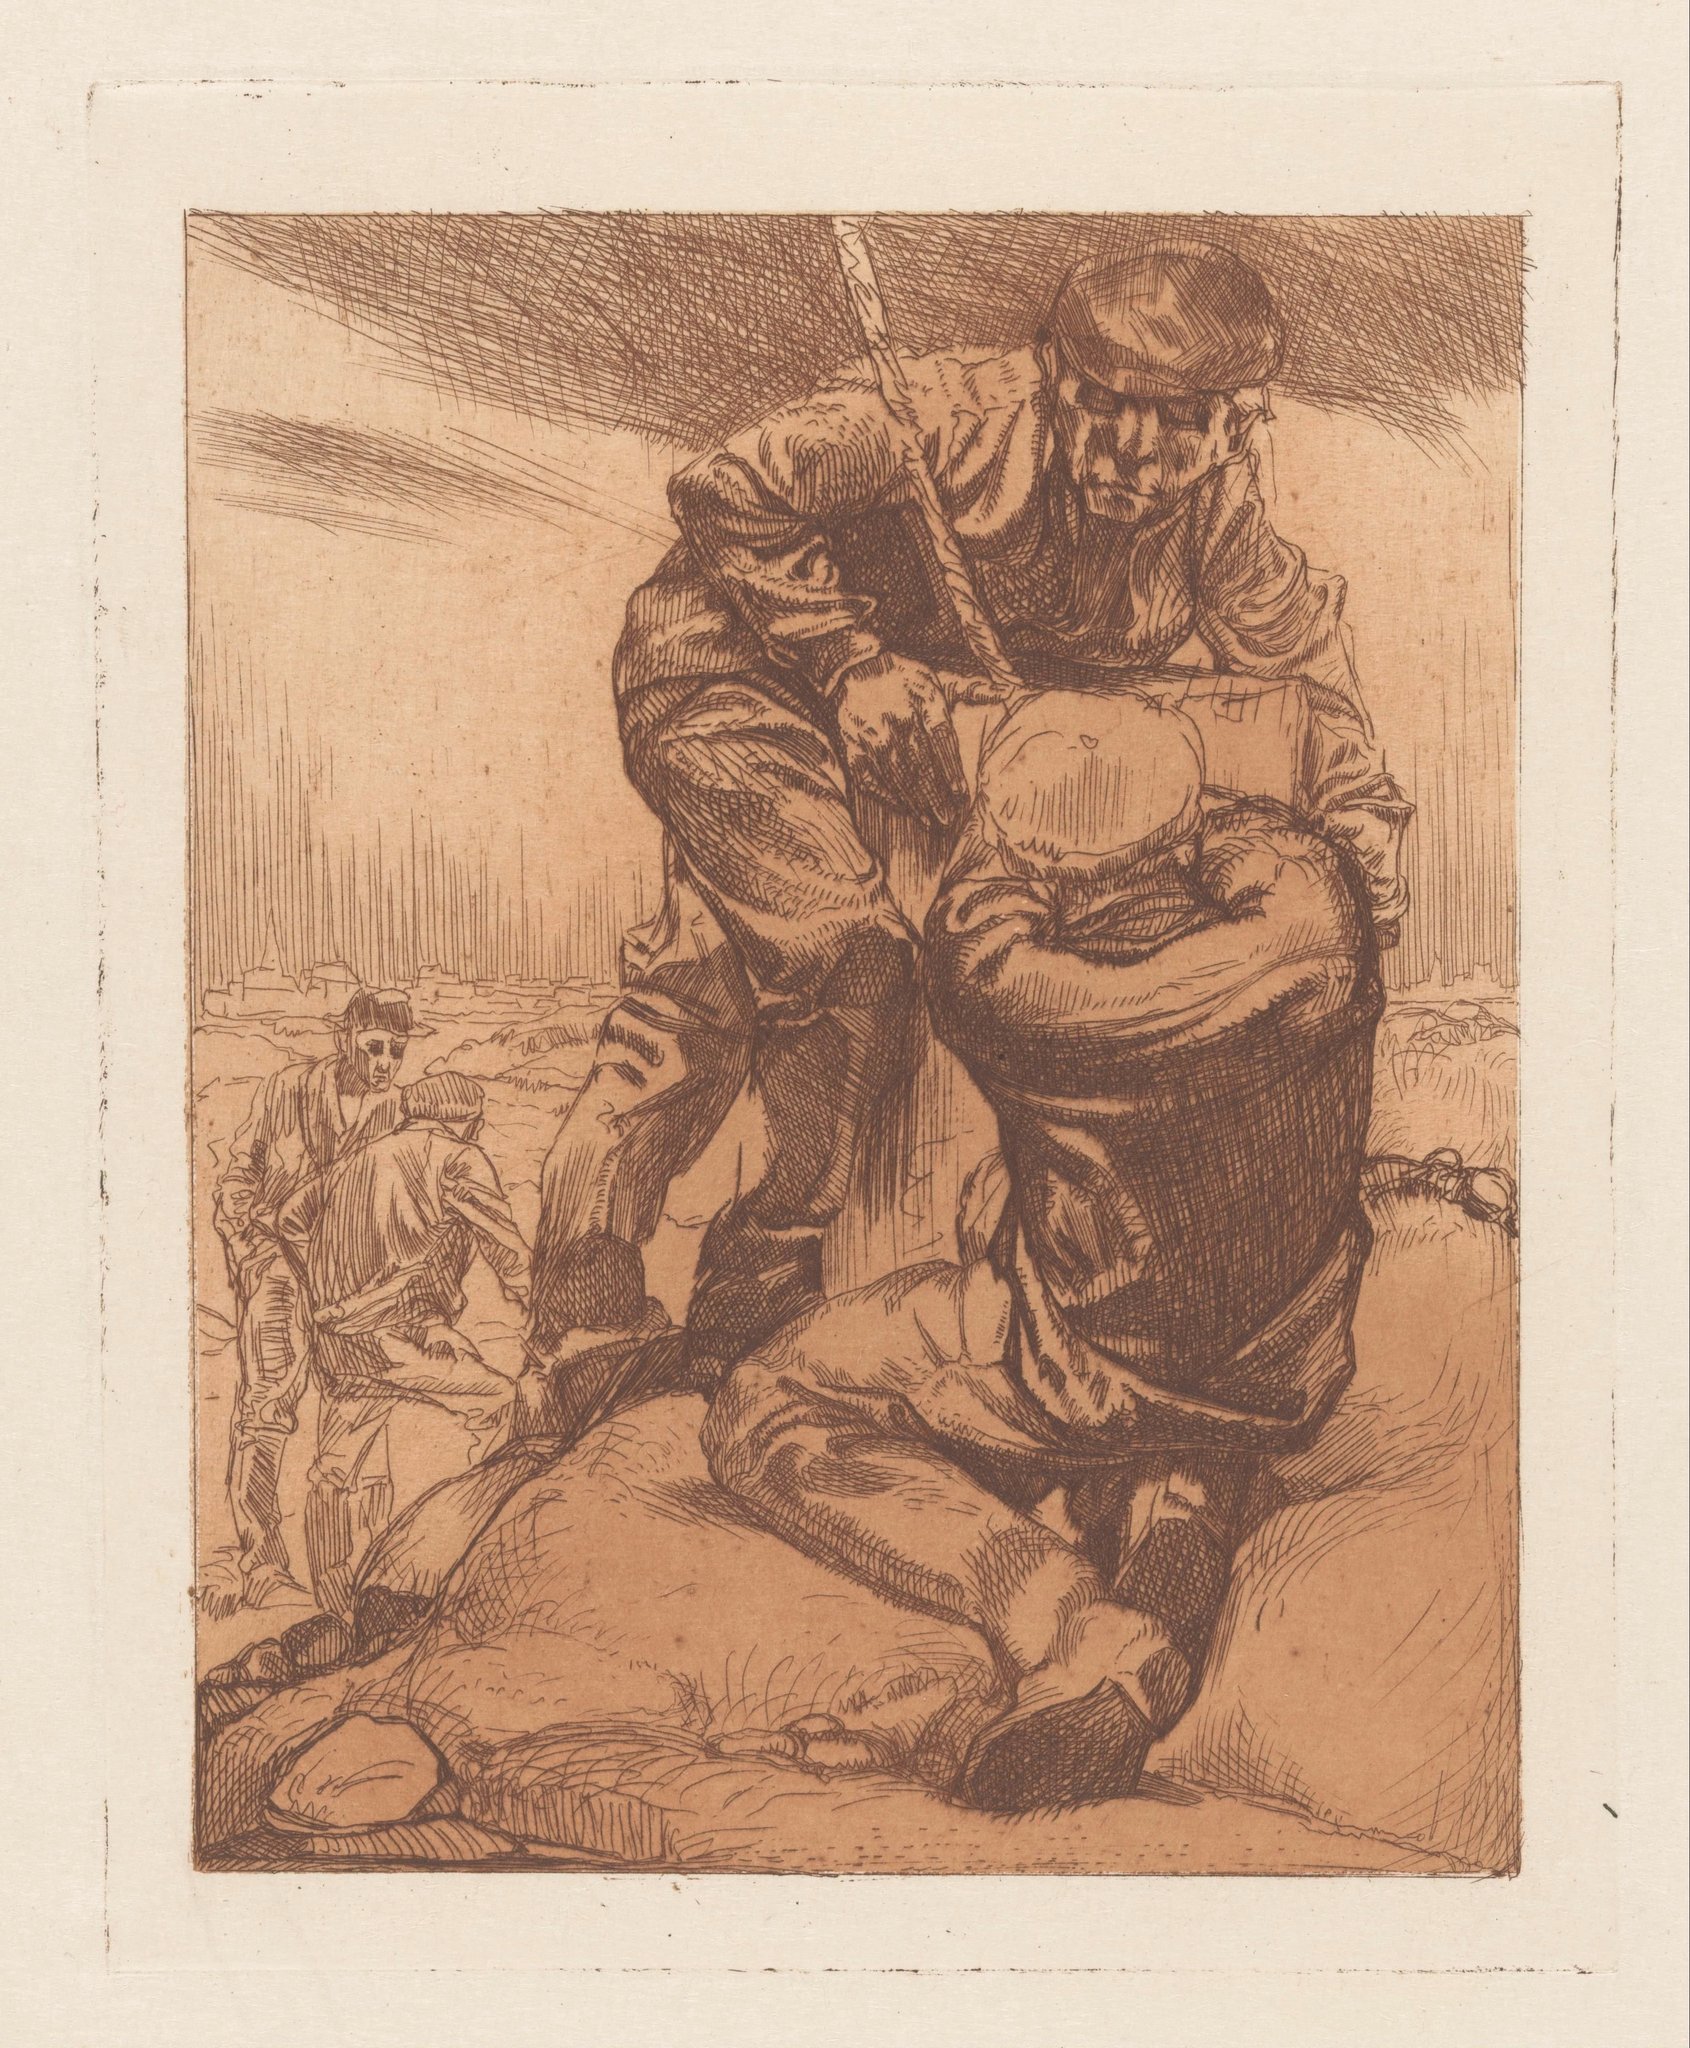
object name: print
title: Vier polderjongens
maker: johannes josephus aarts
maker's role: draughtsman, print maker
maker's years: 1871-1934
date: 1881-1934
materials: paper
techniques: etching, intaglio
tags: working class, labourers, polder, reclaimed land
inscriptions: collector's mark: Lugt 2228, collector's mark: Lugt 2760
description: Vier polderwerkers, waarvan twee op de voorgrond en twee op de voorgrond. De voorste twee verplaatsen een blok met behulp van een touw.